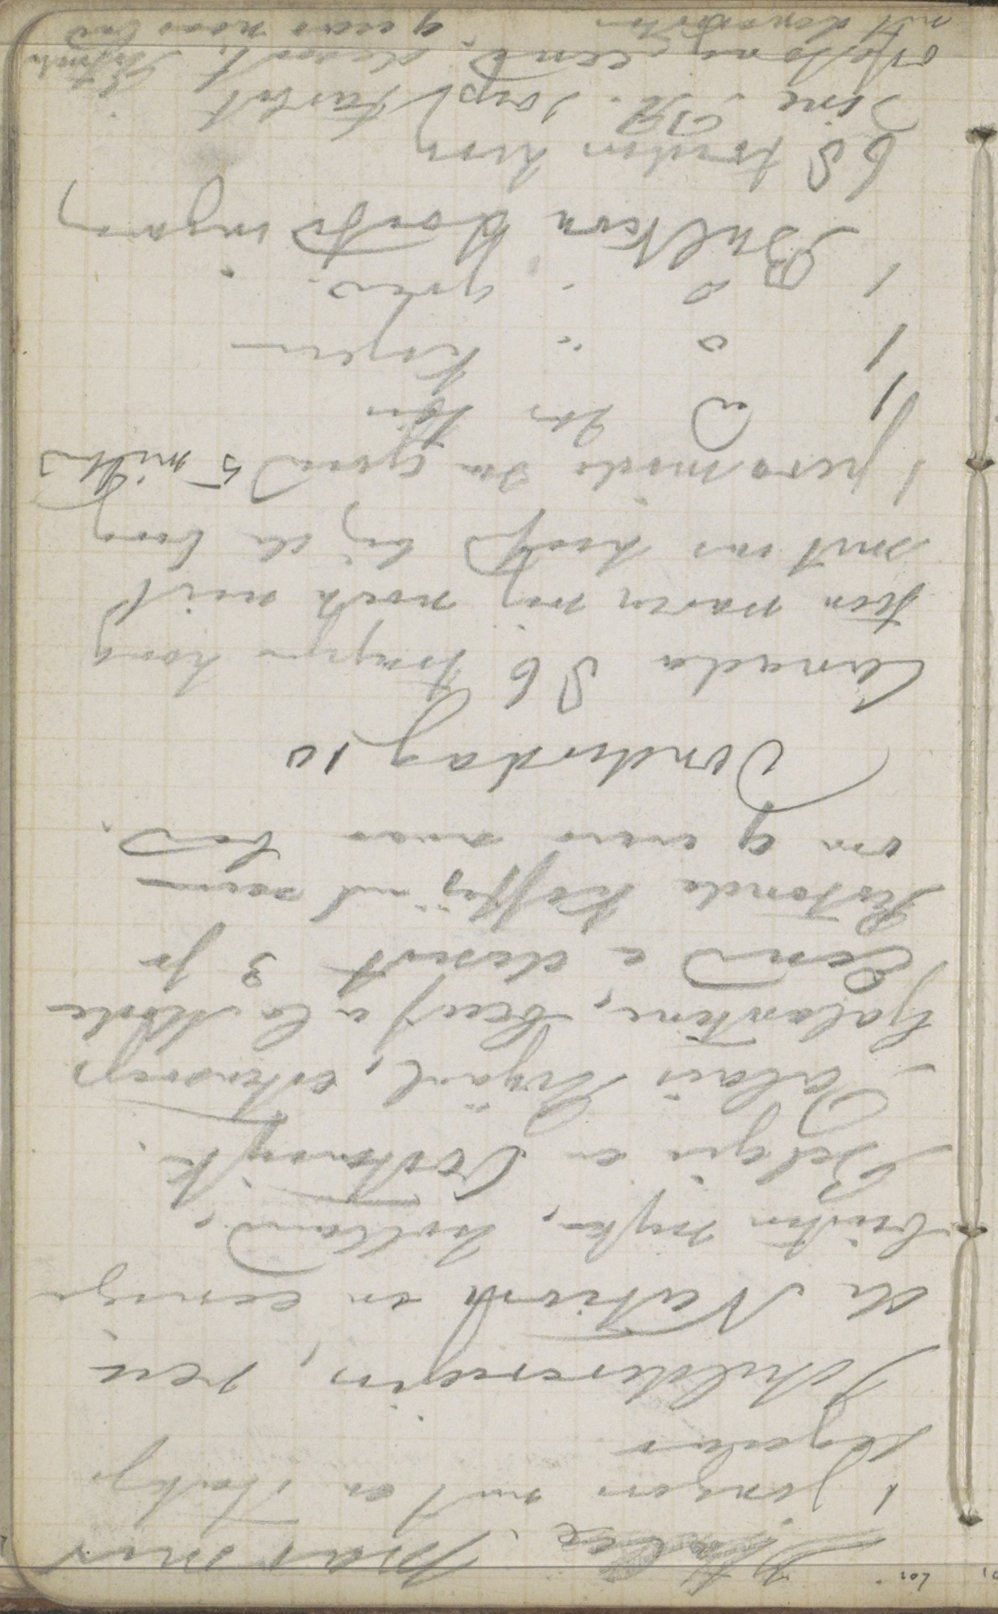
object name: sketchbook leaf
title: Blad met notities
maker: marius bauer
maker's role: draughtsman, print maker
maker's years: 1867-1932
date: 1879-1885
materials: pencil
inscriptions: annotation: ‘Italië marmer/ 1 jongen [...] schilderijen, rue/ de Nation en eenige/ buiten wijken, holland/ België en Oostenrijk./ Palais Royal ’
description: Pagina 107 uit een schetsboek met 58 bladen.